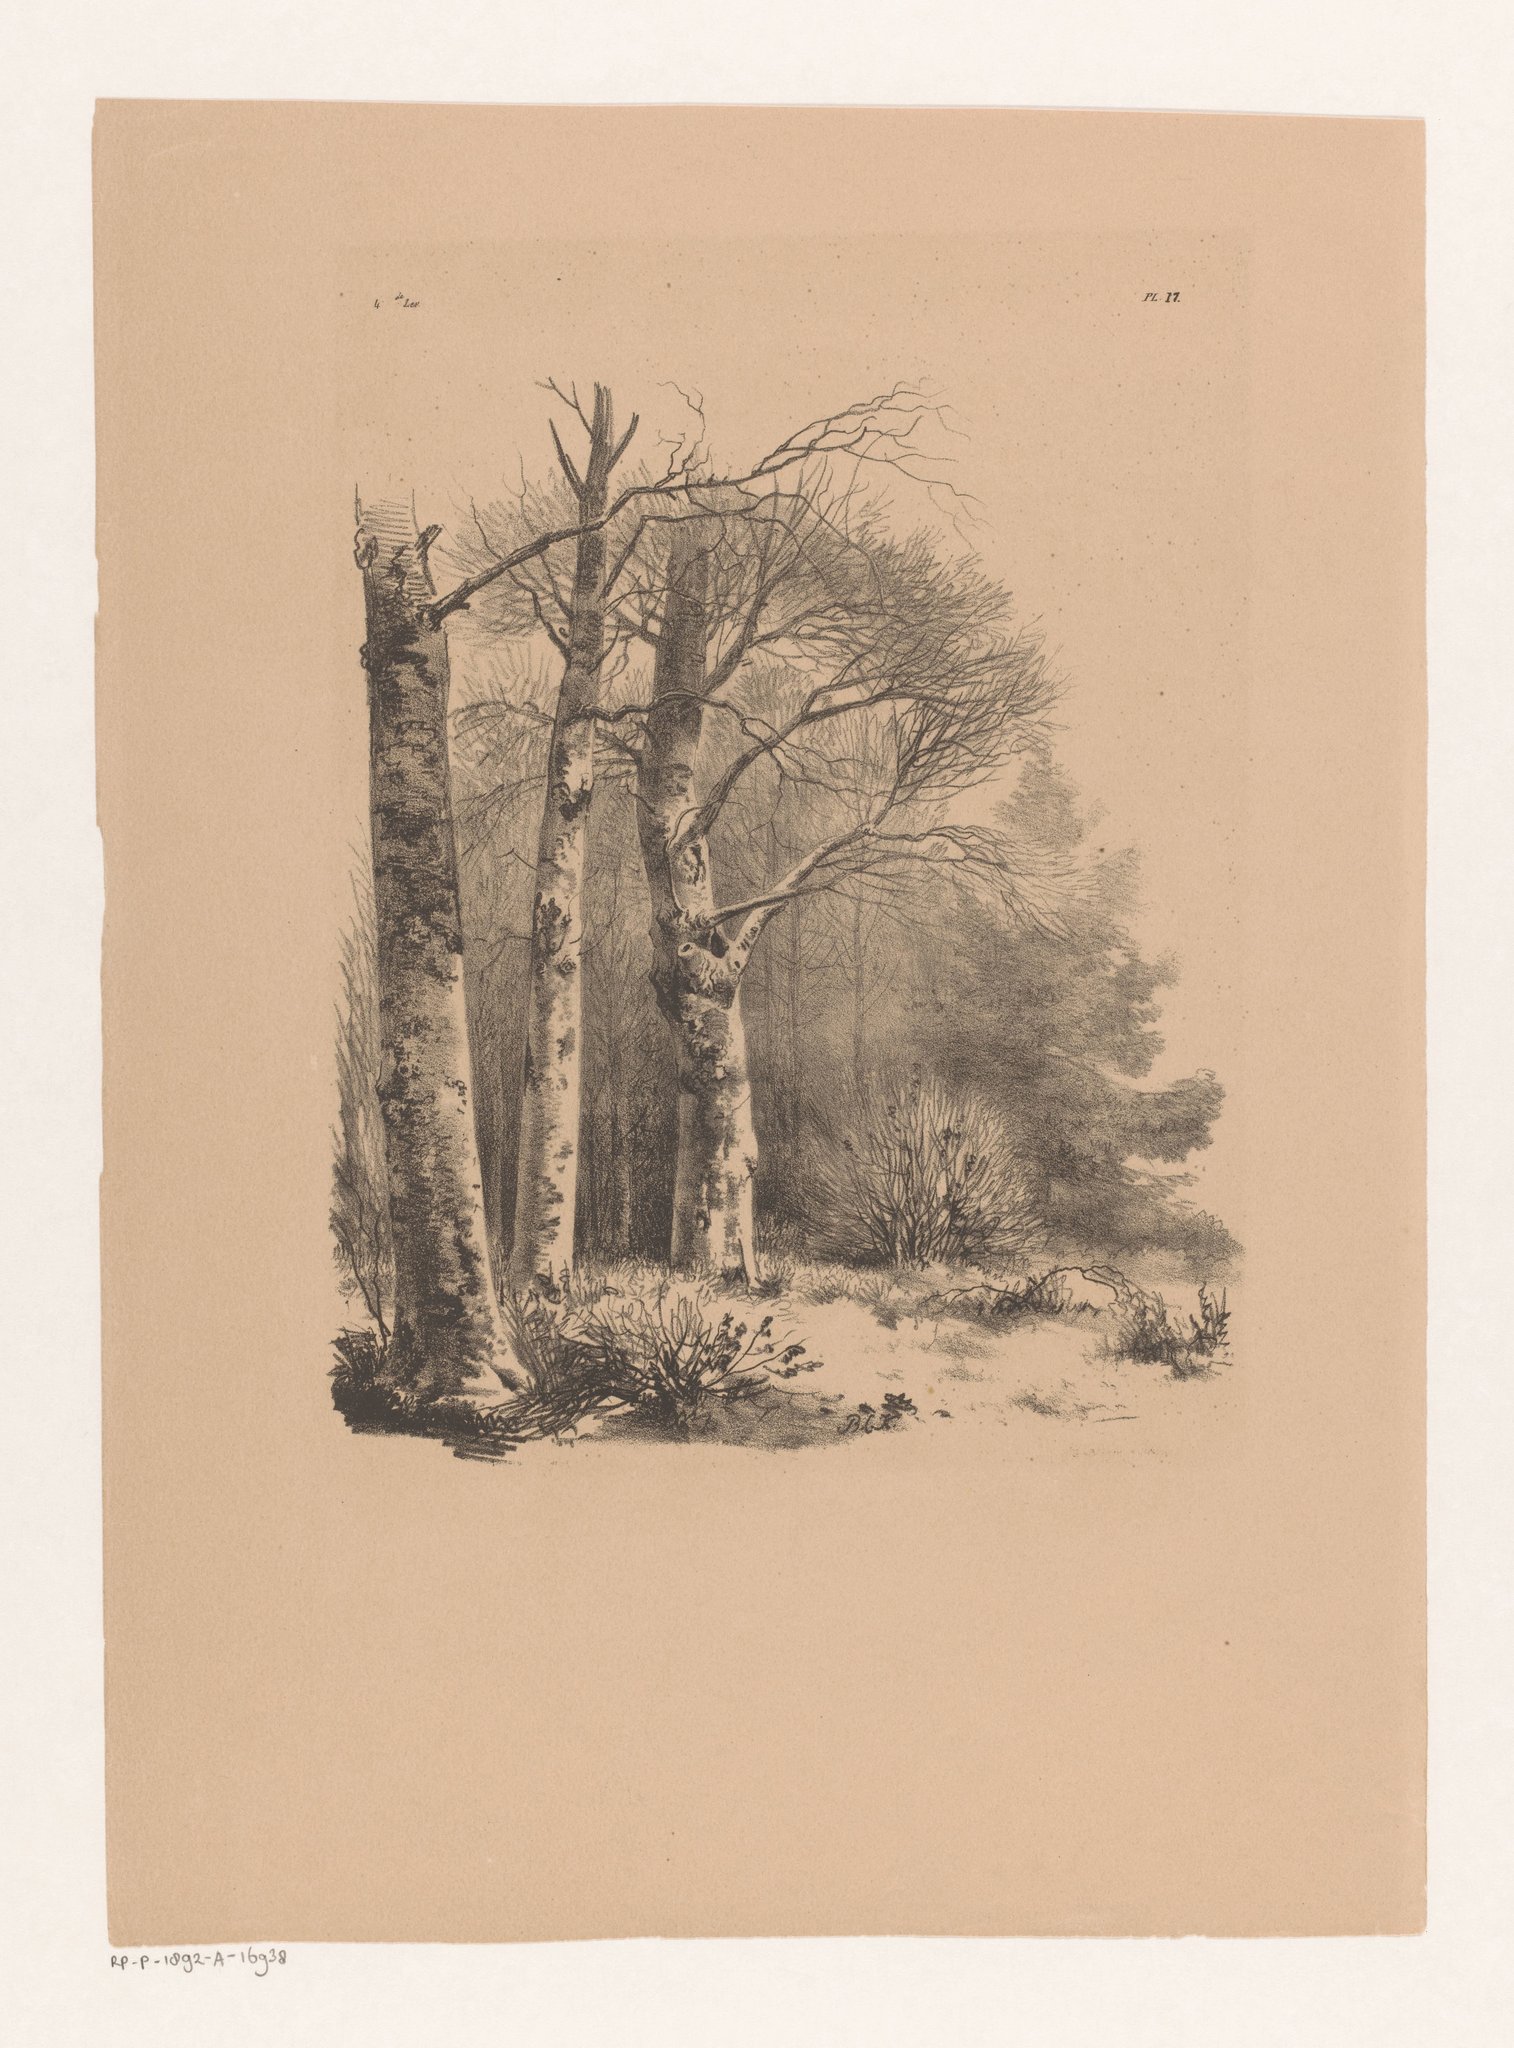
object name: print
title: Drie bomen in een bos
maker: barend cornelis koekkoek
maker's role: draughtsman, painter, print maker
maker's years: 1803-1862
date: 1844-1845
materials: paper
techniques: lithograph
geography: amsterdam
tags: forest, wood, groups of trees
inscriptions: collector's mark: Lugt 2228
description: In 1829 en 1830 gaf Koekkoek, samen met Daiwaille, zes cahiers uit met ieder zes prenten getiteld Landschapstudiën. Deze werden gebruikt in het tekenonderwijs. Vijftien jaar later werd deze reeks, in een andere samenstelling nogmaals uitgegeven door Meyer en Comp in Amsterdam. Zie: De Bruyn Kops, 1963.